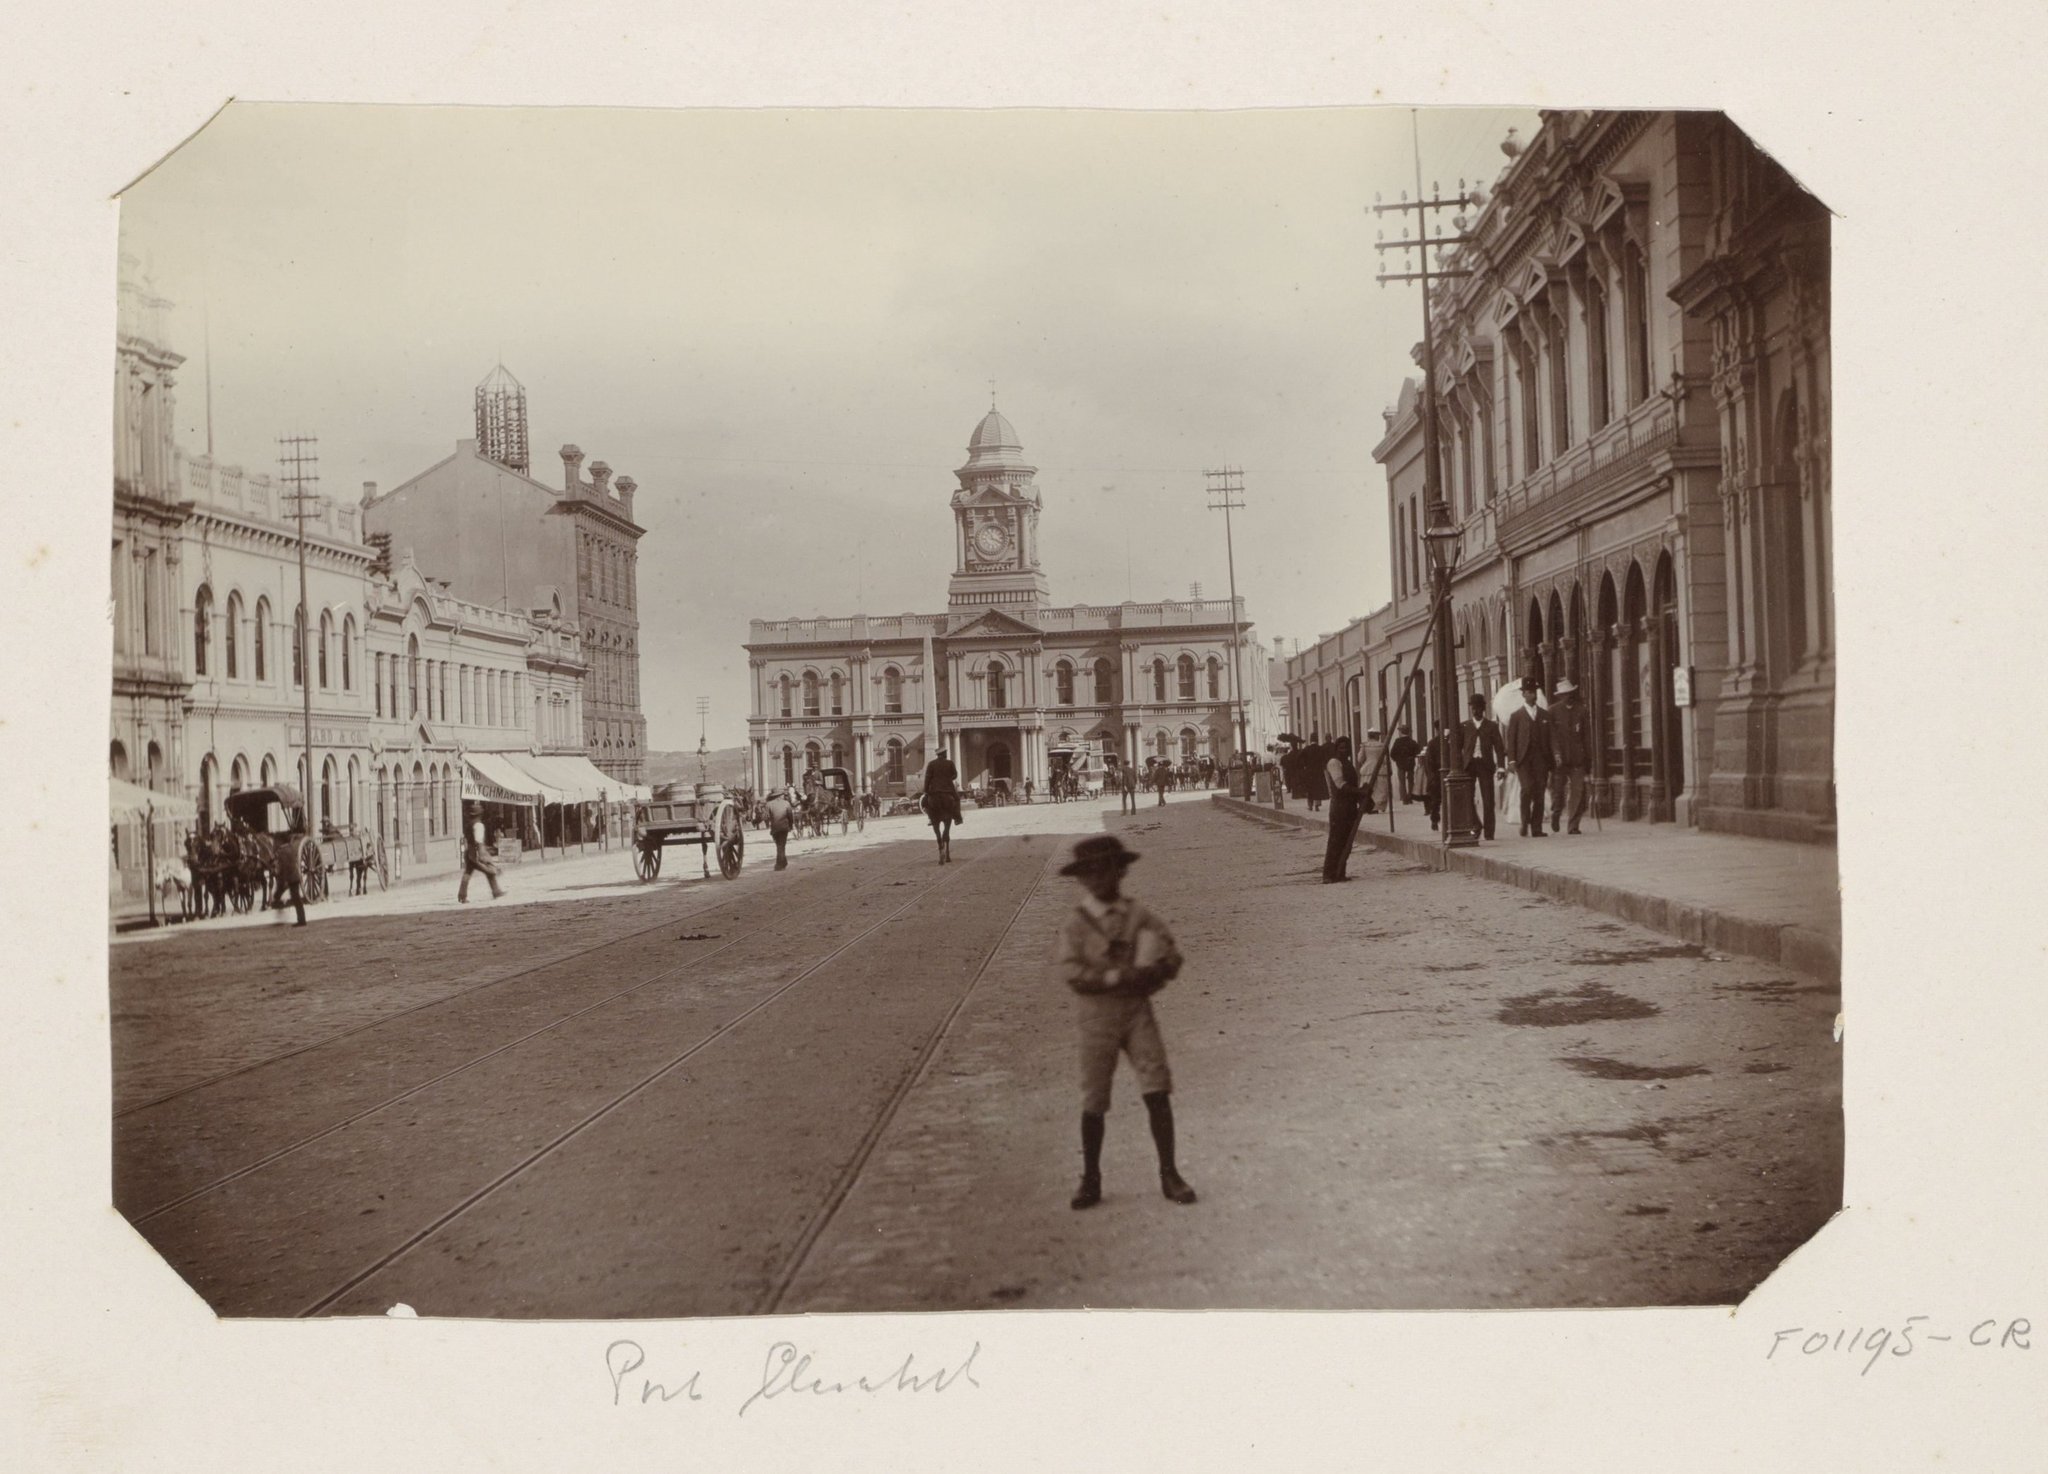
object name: photograph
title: Mainstreet in Port Elizabeth met aan het einde het stadhuis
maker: Anonymous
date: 1880-1910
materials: cardboard, paper, photographic support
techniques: gelatin silver print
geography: port elizabeth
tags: animal traction, animal-drawn vehicle (carriage etc.), street (+ city(-scape) with figures, staffage)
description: Onderdeel van Fotoalbum van een reis door de Verenigde Staten, Honolulu, Nederlands-Indië, Aden, Zanzibar en Zuidelijk Afrika.